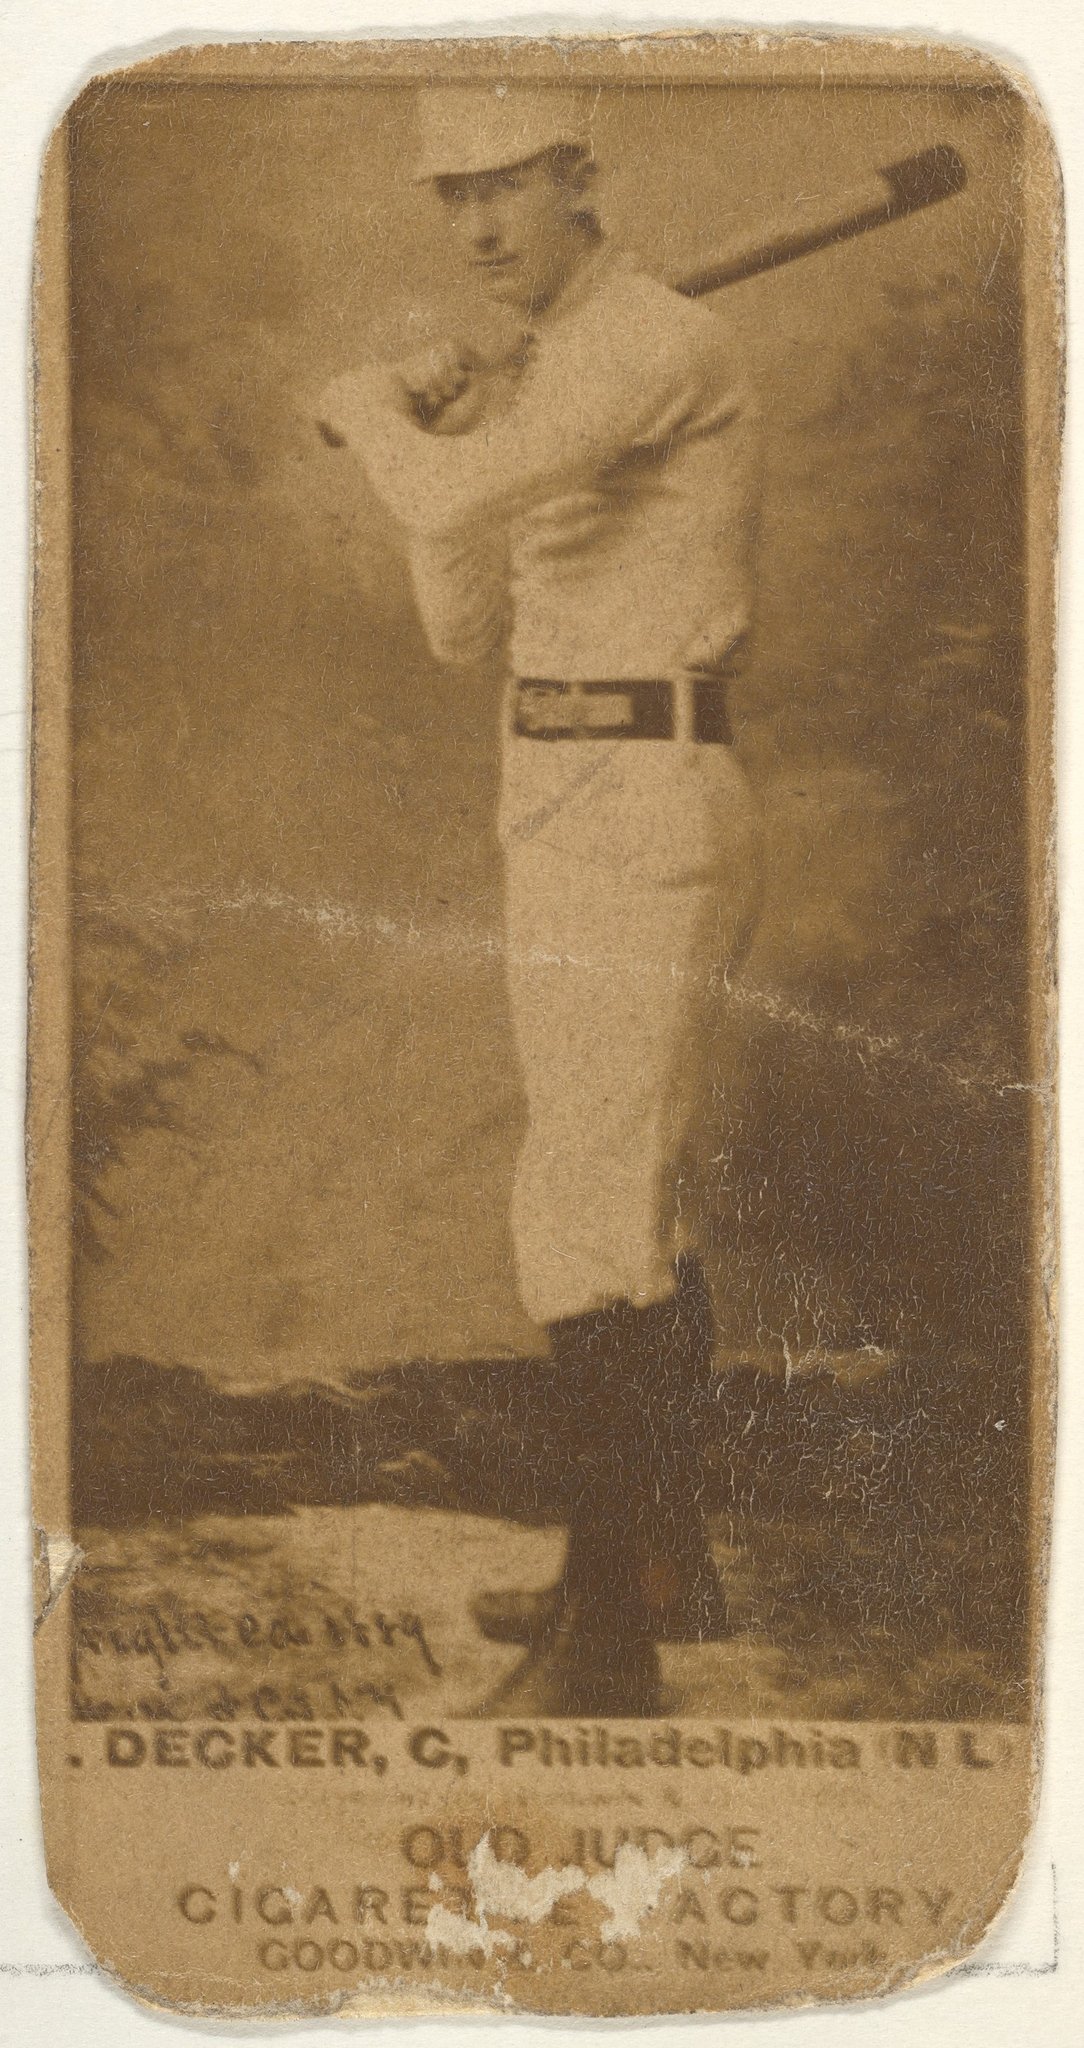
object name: baseball card, photograph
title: Decker, Catcher, Philadelphia, from the Old Judge series (N172) for Old Judge Cigarettes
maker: goodwin & company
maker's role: publisher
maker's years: 1850-1950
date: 1887-1890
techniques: albumen silver print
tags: men,portraits,baseball,athletes